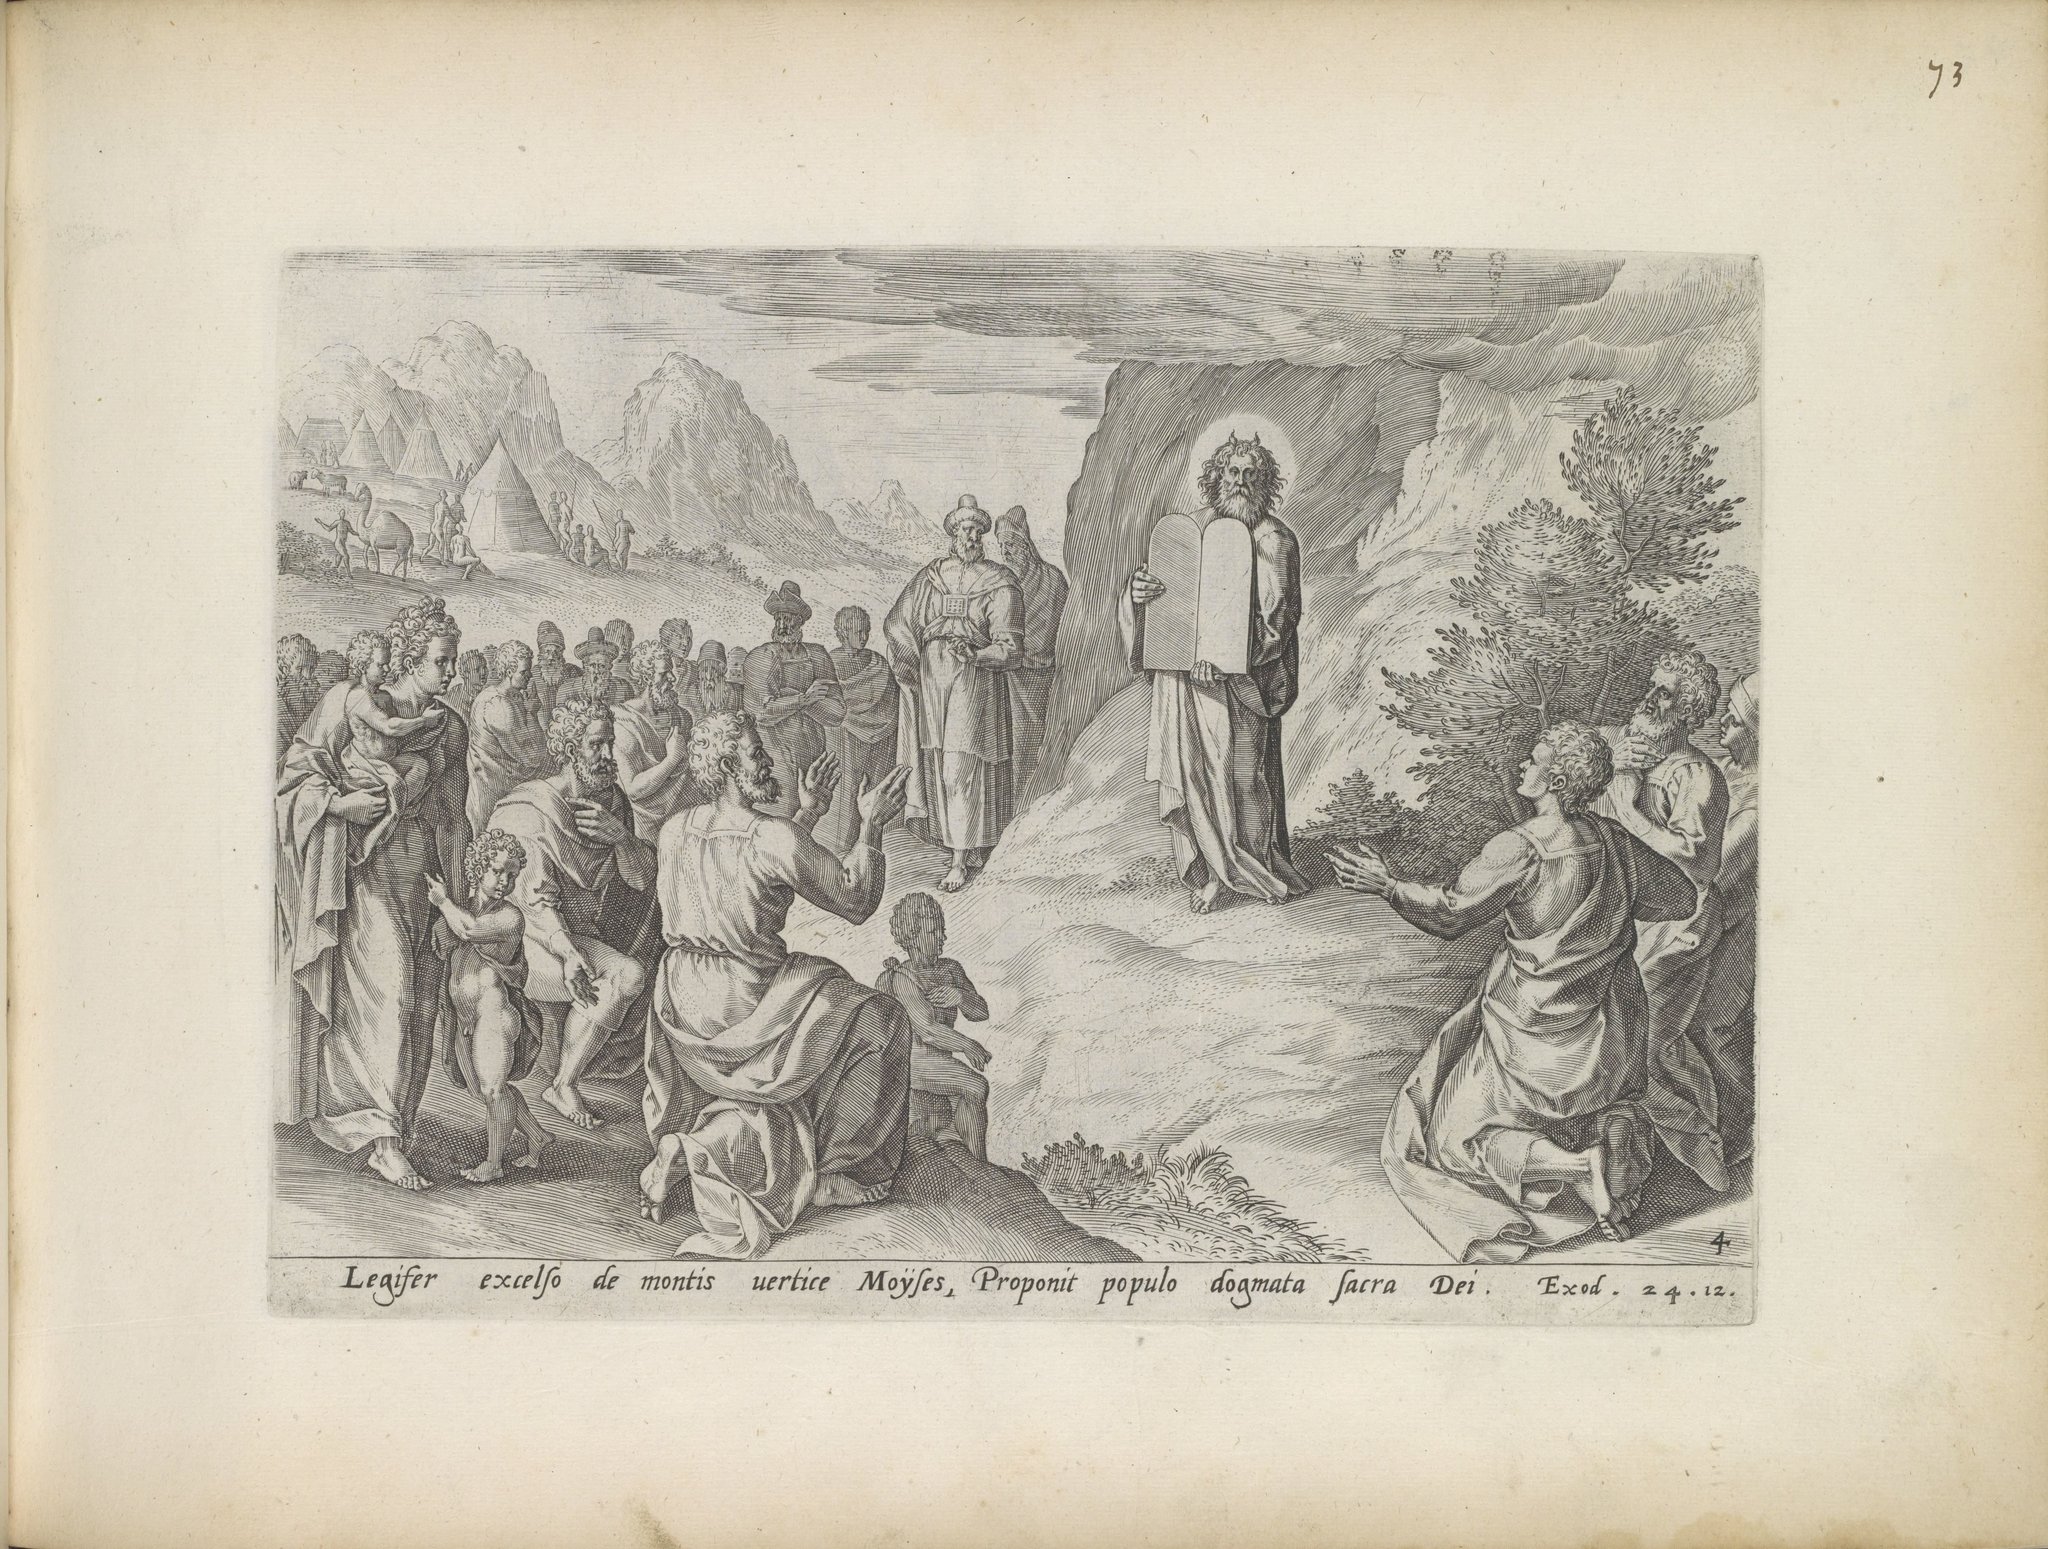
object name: print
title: Geschiedenis van Mozes na de Exodus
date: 1579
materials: paper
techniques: engraving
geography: amsterdam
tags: moses comes down with the new tablets and is awaited by aaron and the assembled people, who notice that 'his face is shining' (moses' face is depicted with rays of light or with horns)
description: Claes Jansz. Visscher combineerde in Theatrum Biblicum de serie Geschiedenis van Mozes na de Exodus van Johann Sadeler (I) naar Crispijn van den Broeck (6 prenten) en de serie Geschiedenis van Bileam van een anonieme prentmaker naar Maarten de Vos (4 prenten) tot een serie van tien prenten.